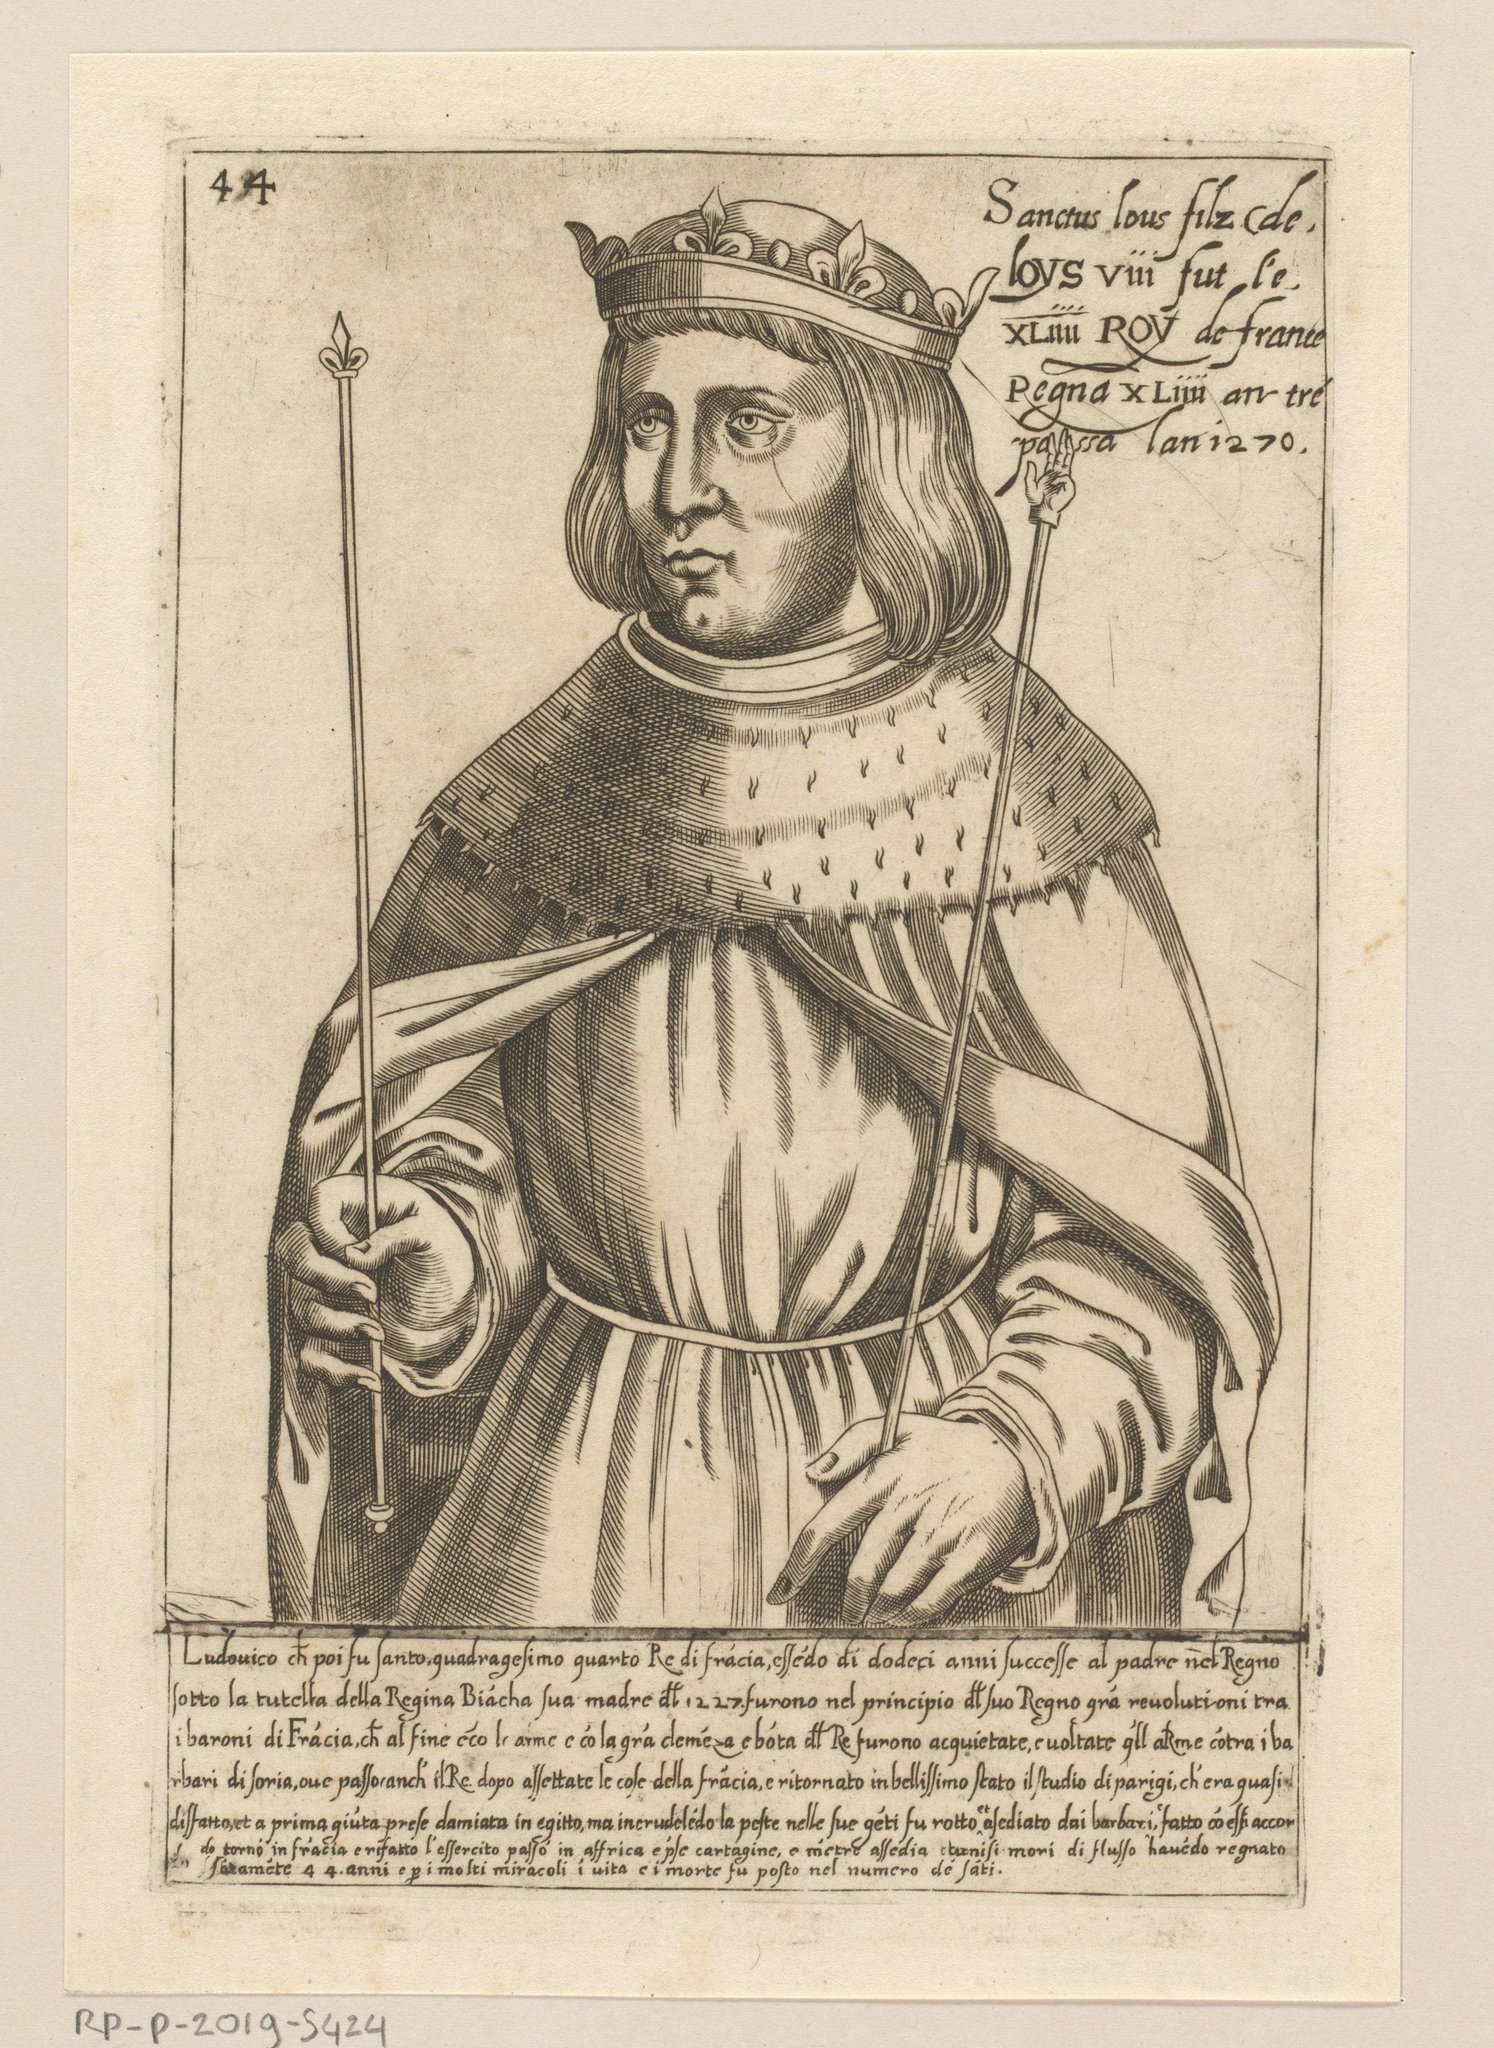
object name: print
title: Portret van Lodewijk IX de Heilige, koning van Frankrijk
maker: Anonymous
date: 1588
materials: paper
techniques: engraving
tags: crown (symbol of sovereignty), sceptre, staff (symbol of sovereignty), historical persons, louis ix, king of france; possible attributes: crown of thorns, fleur-de-lis on his coat, three nails, sceptre with fleur-de-lis, model of church, hand of justice, king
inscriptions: collector's mark: Lugt 2228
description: Prent voor het eerst gebruikt in: Cronica Breve de i fatti illustri de're di Francia, con le loro effigie dal naturale cominciando da Faramondo (...). Venetië: Bernardo Giunti, 1588. Prent in ieder geval ook gebruikt in de editie van 1590 en mogelijk ook in een Franse uitgave van 1597.